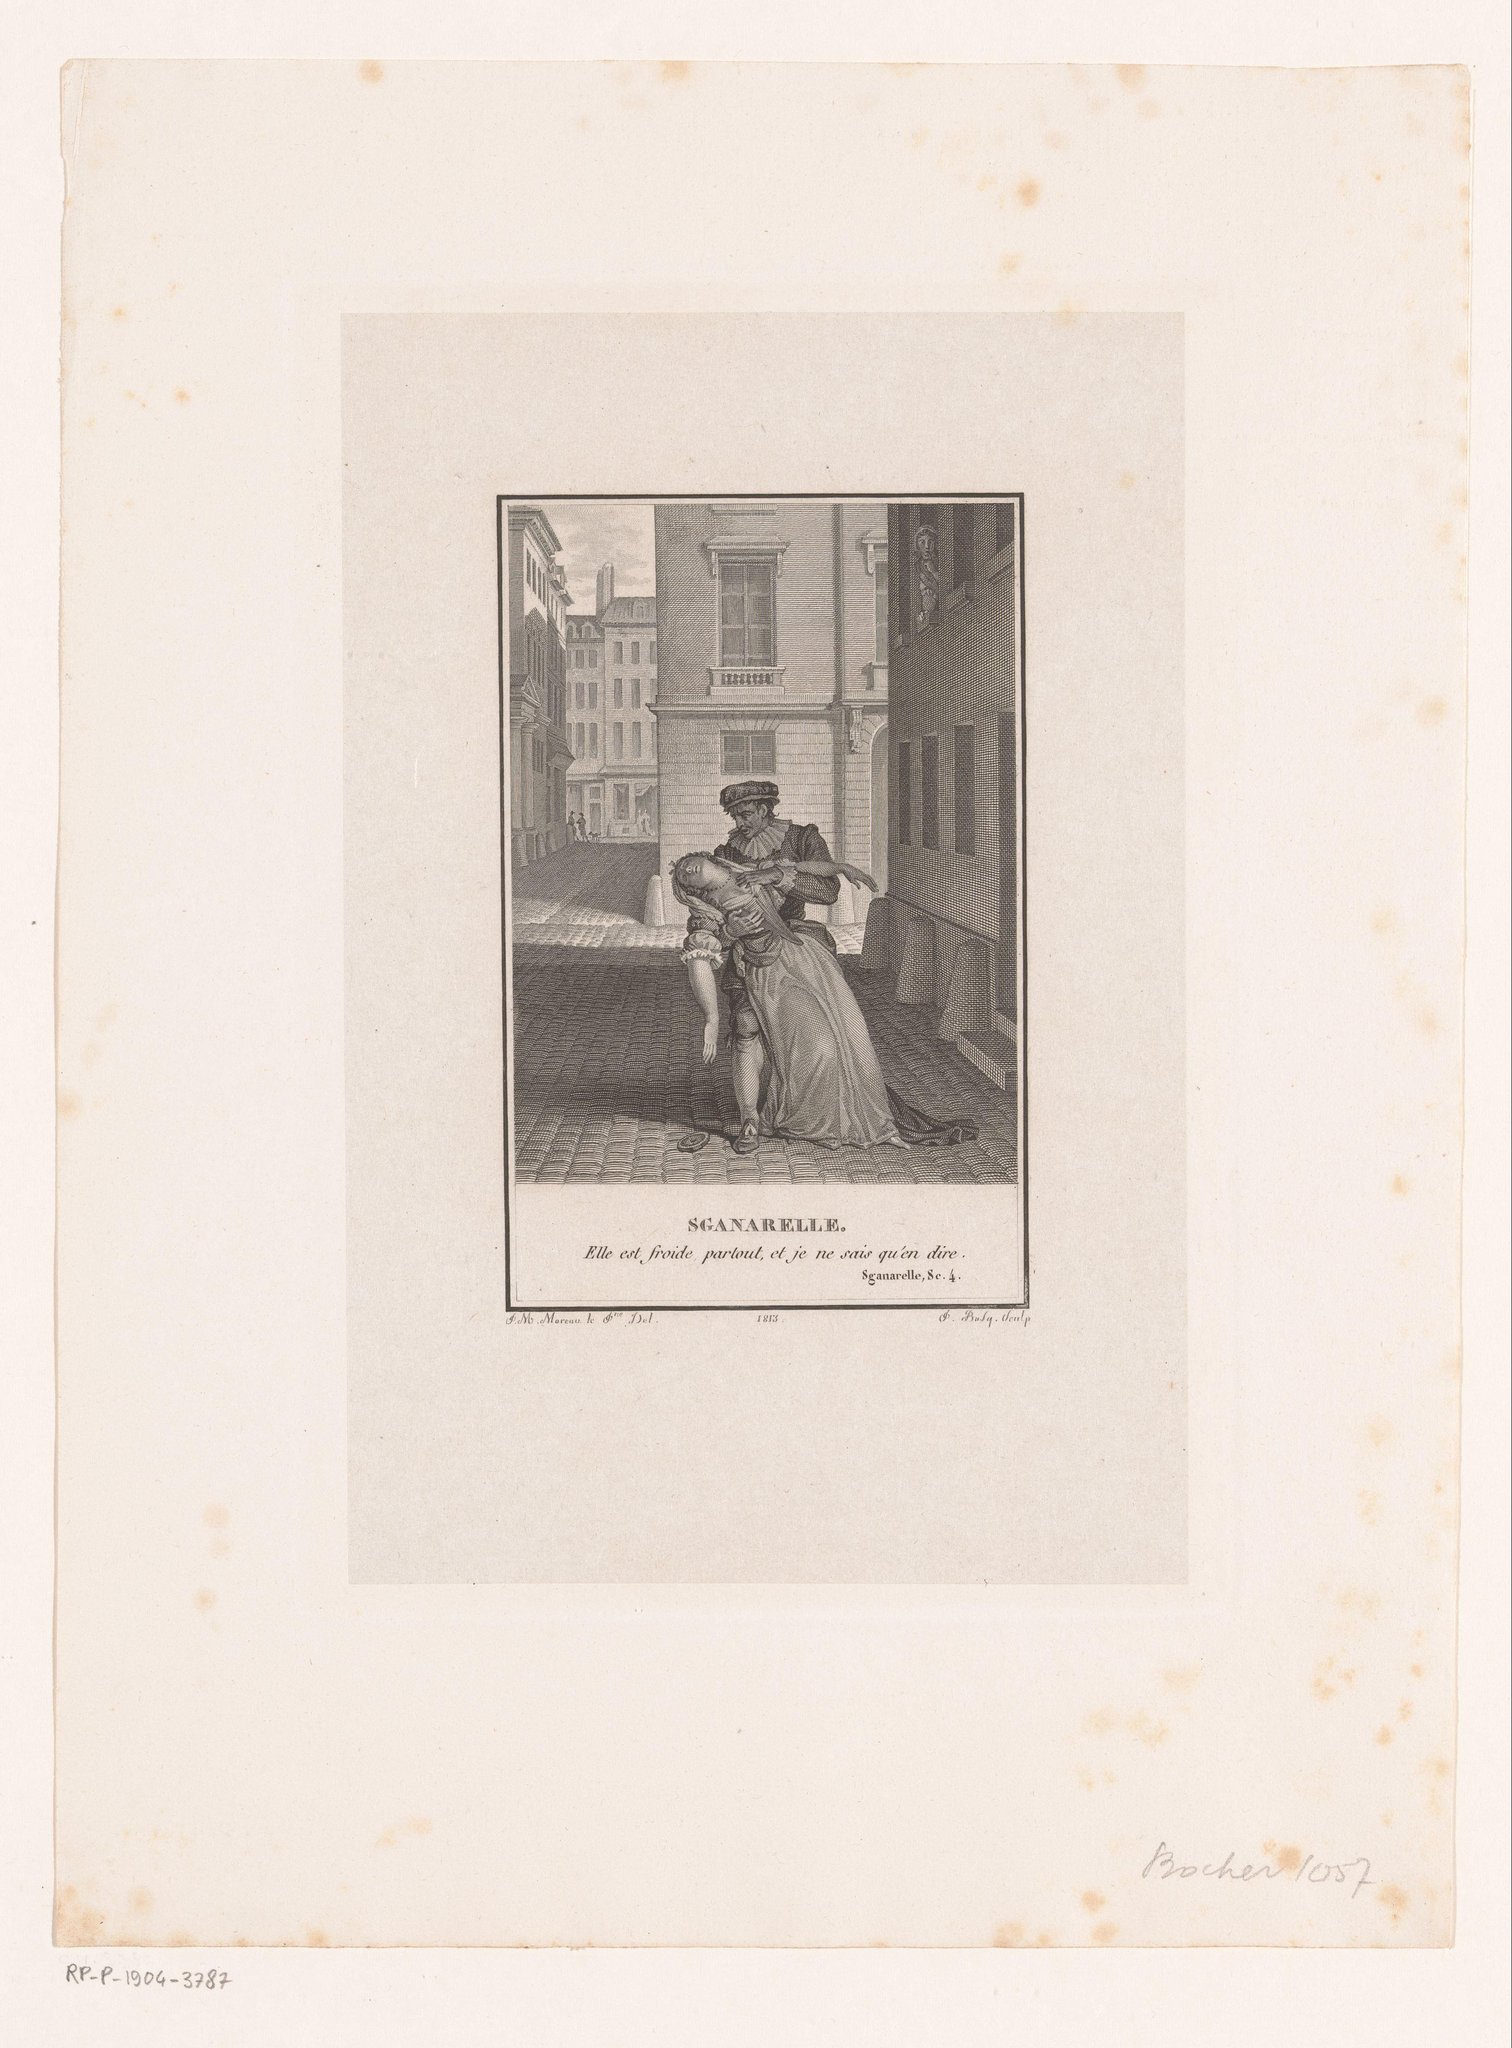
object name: print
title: Sganarelle houdt de flauwgevallen Célie in zijn armen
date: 1813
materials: paper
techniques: engraving, etching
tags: theatre, theatrical performance, fainting, swooning - bb - out of doors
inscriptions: collector's mark: Lugt 2228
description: Prent van scène vier uit 'Sganarelle' door Jean Baptiste Molière. Dit betreft een van de dertig prenten, gemaakt in opdracht van Antoine Augustin Renouard, bestemd voor verschillende edities van Molières werk daterend van 1811 tot 1813. De prenten zijn vervaardigd door verschillende kunstenaars naar composities van Moreau.